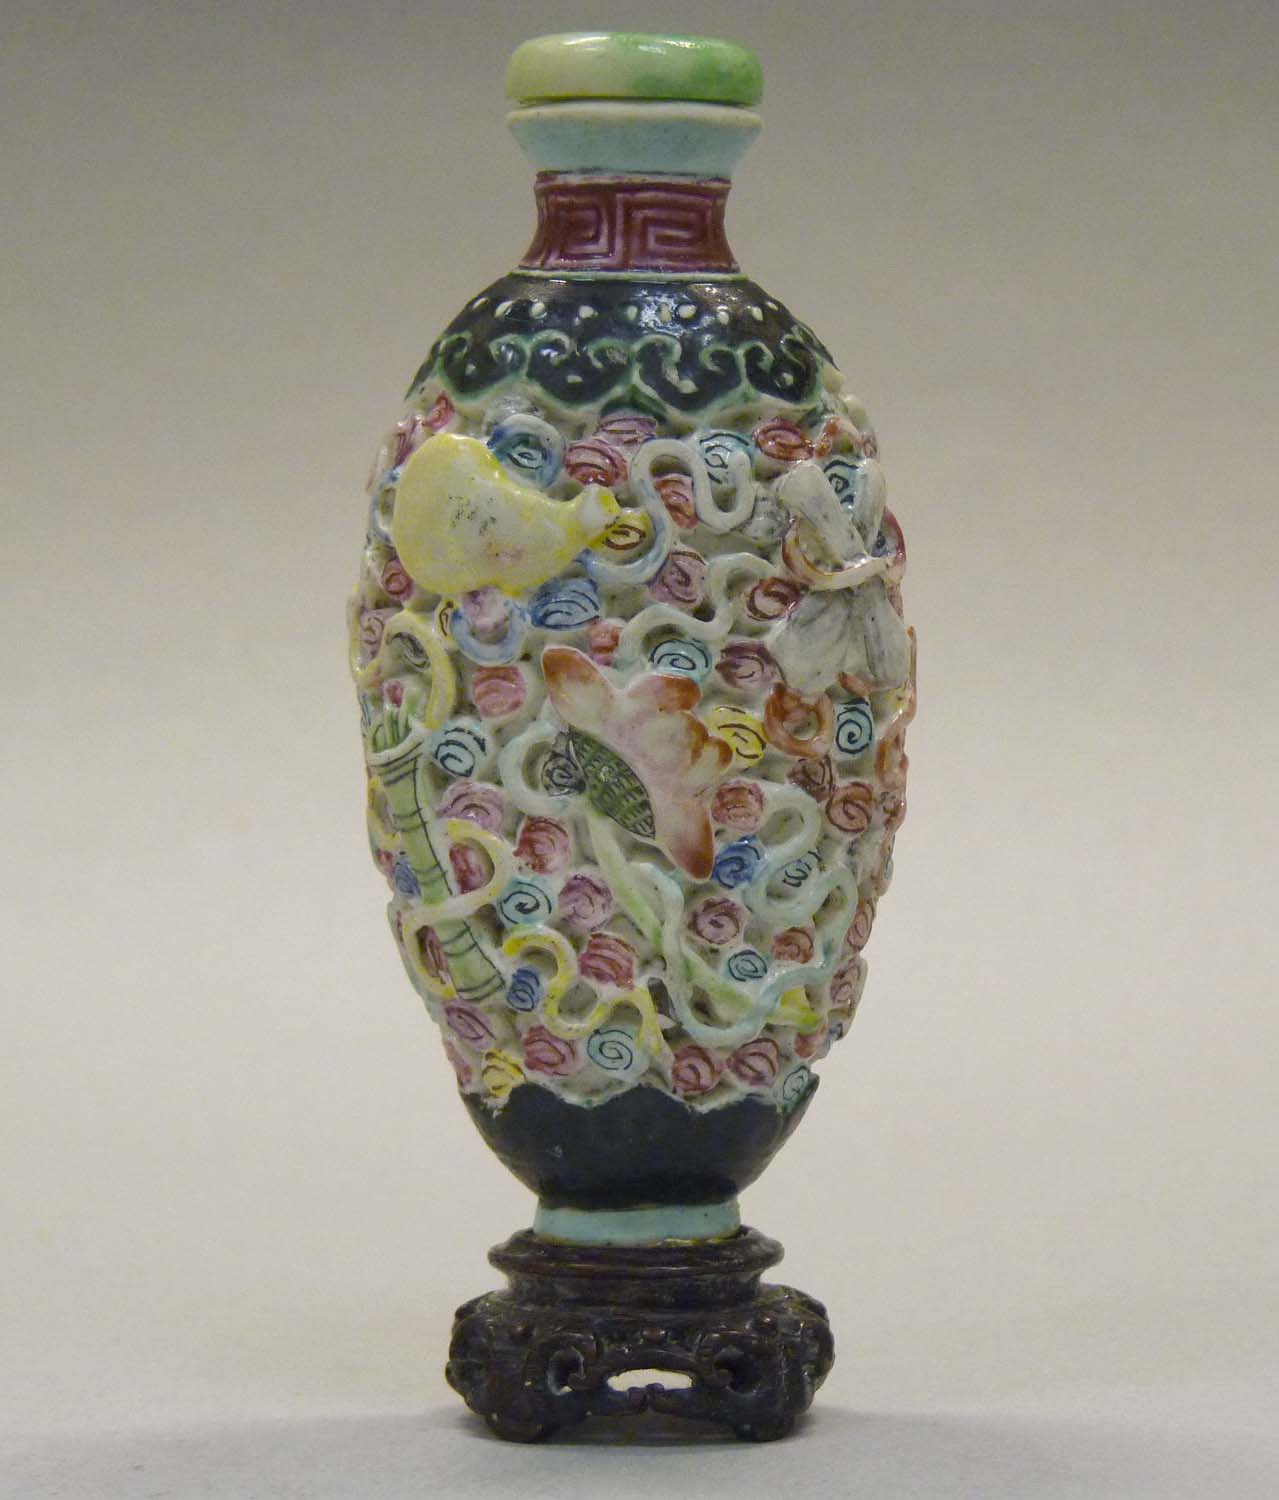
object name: snuff bottle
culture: chinese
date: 1801-1900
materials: jade, porcelain